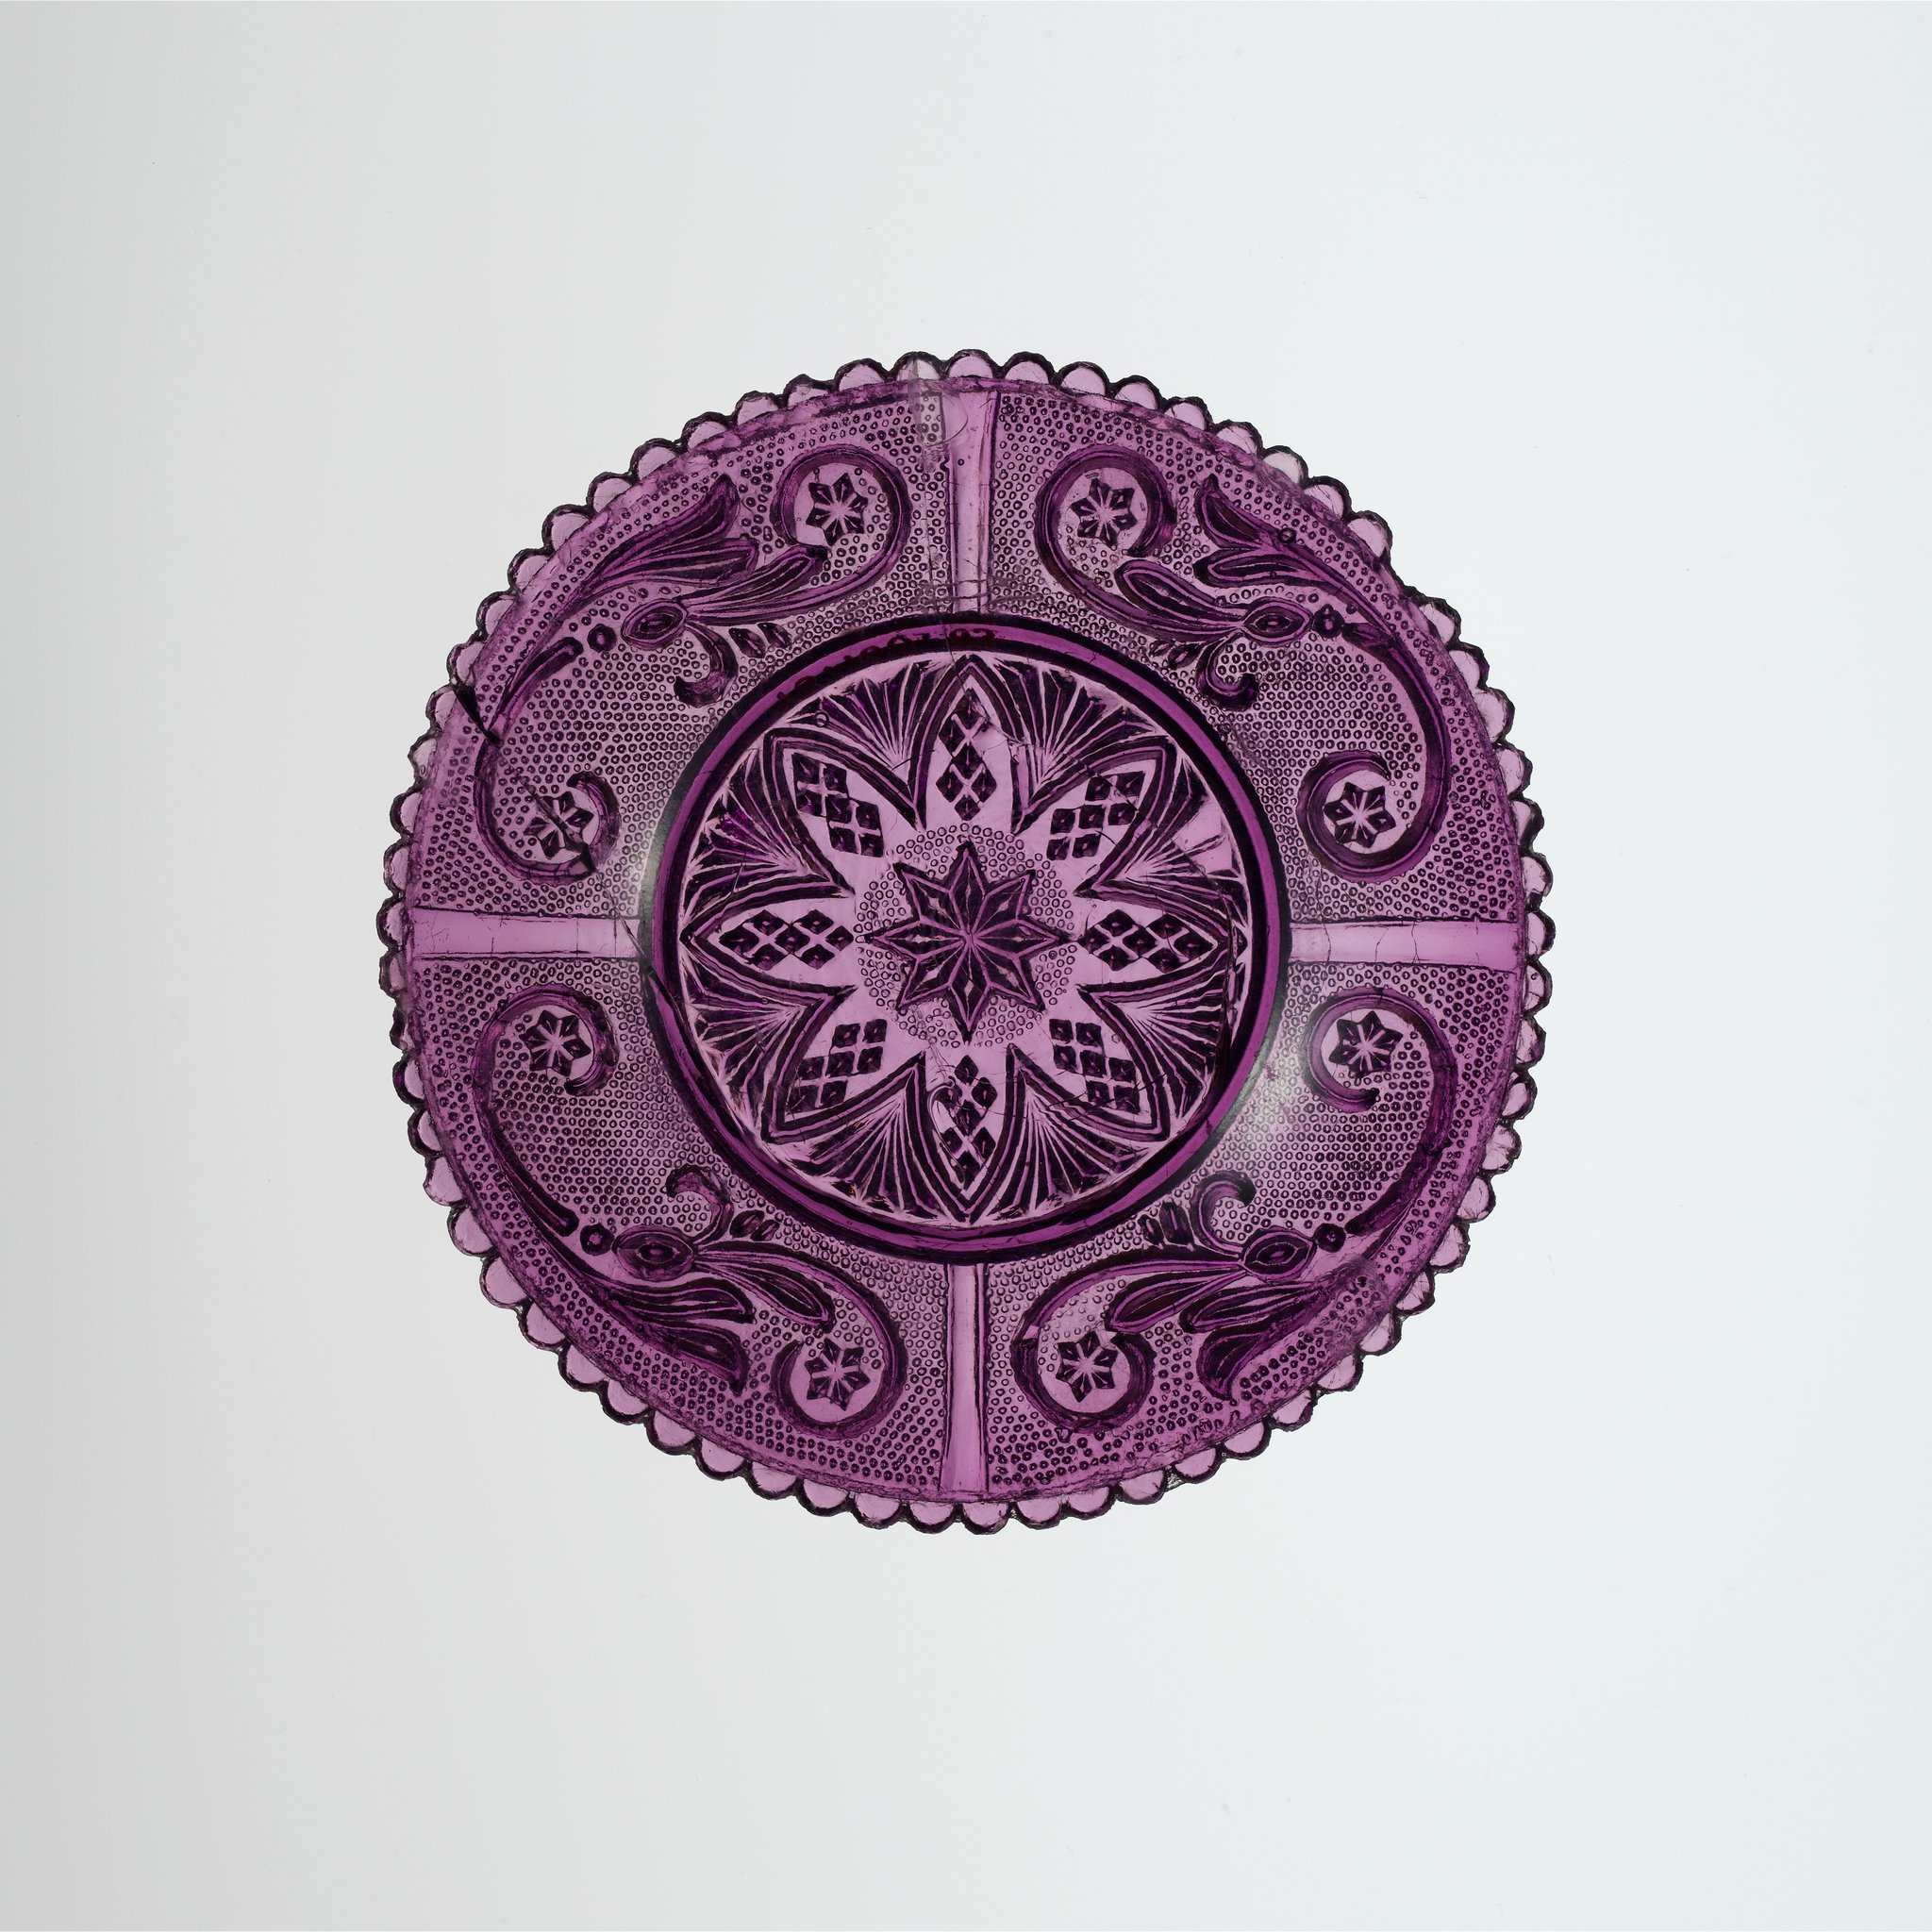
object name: cup plate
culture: american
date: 1825-1860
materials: glass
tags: flowers